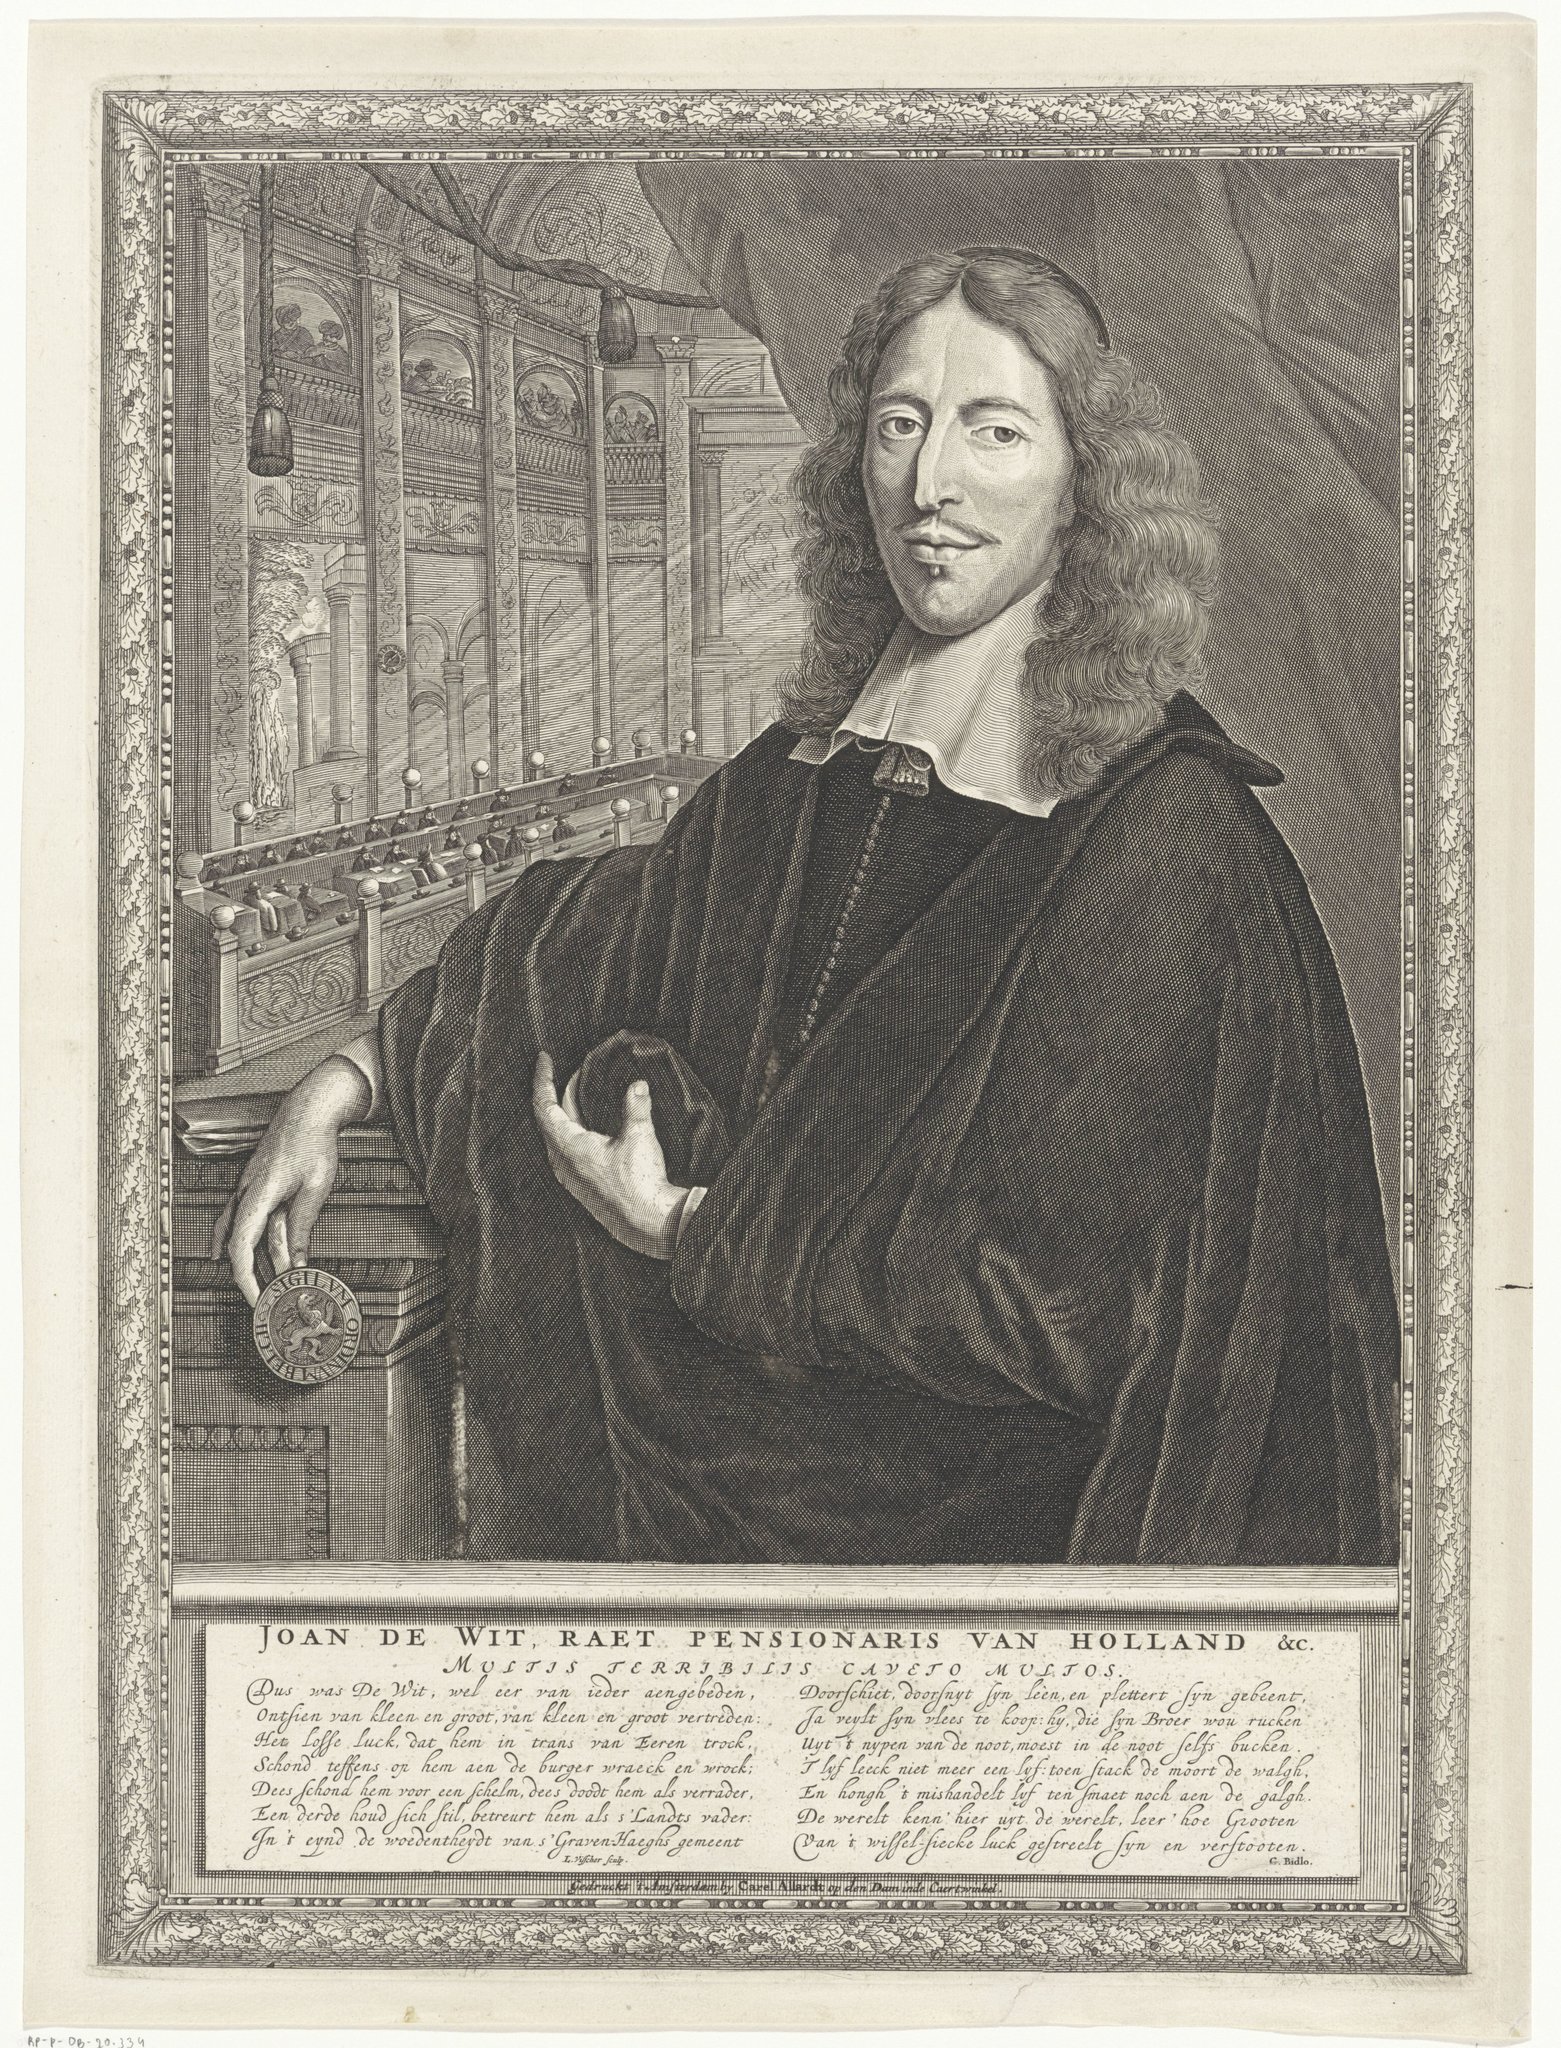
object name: print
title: Portret van Johan de Witt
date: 1673-1709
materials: paper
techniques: engraving, etching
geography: amsterdam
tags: the hague, politician, johan de witt, coat (+ men's clothes), seal, stamp, court session (court of justice)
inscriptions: collector's mark: Lugt 2228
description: Portret van de advocaat Johan de Witt, raadpensionaris van het gewest Holland. Hij is gekleed in een mantel en staat voor een gordijn met daarachter een vergaderzaal. In zijn rechterhand heeft hij een zegel met de Nederlandse leeuw, symbool voor de Republiek. Onder zijn portret zijn naam, titel en een vers.